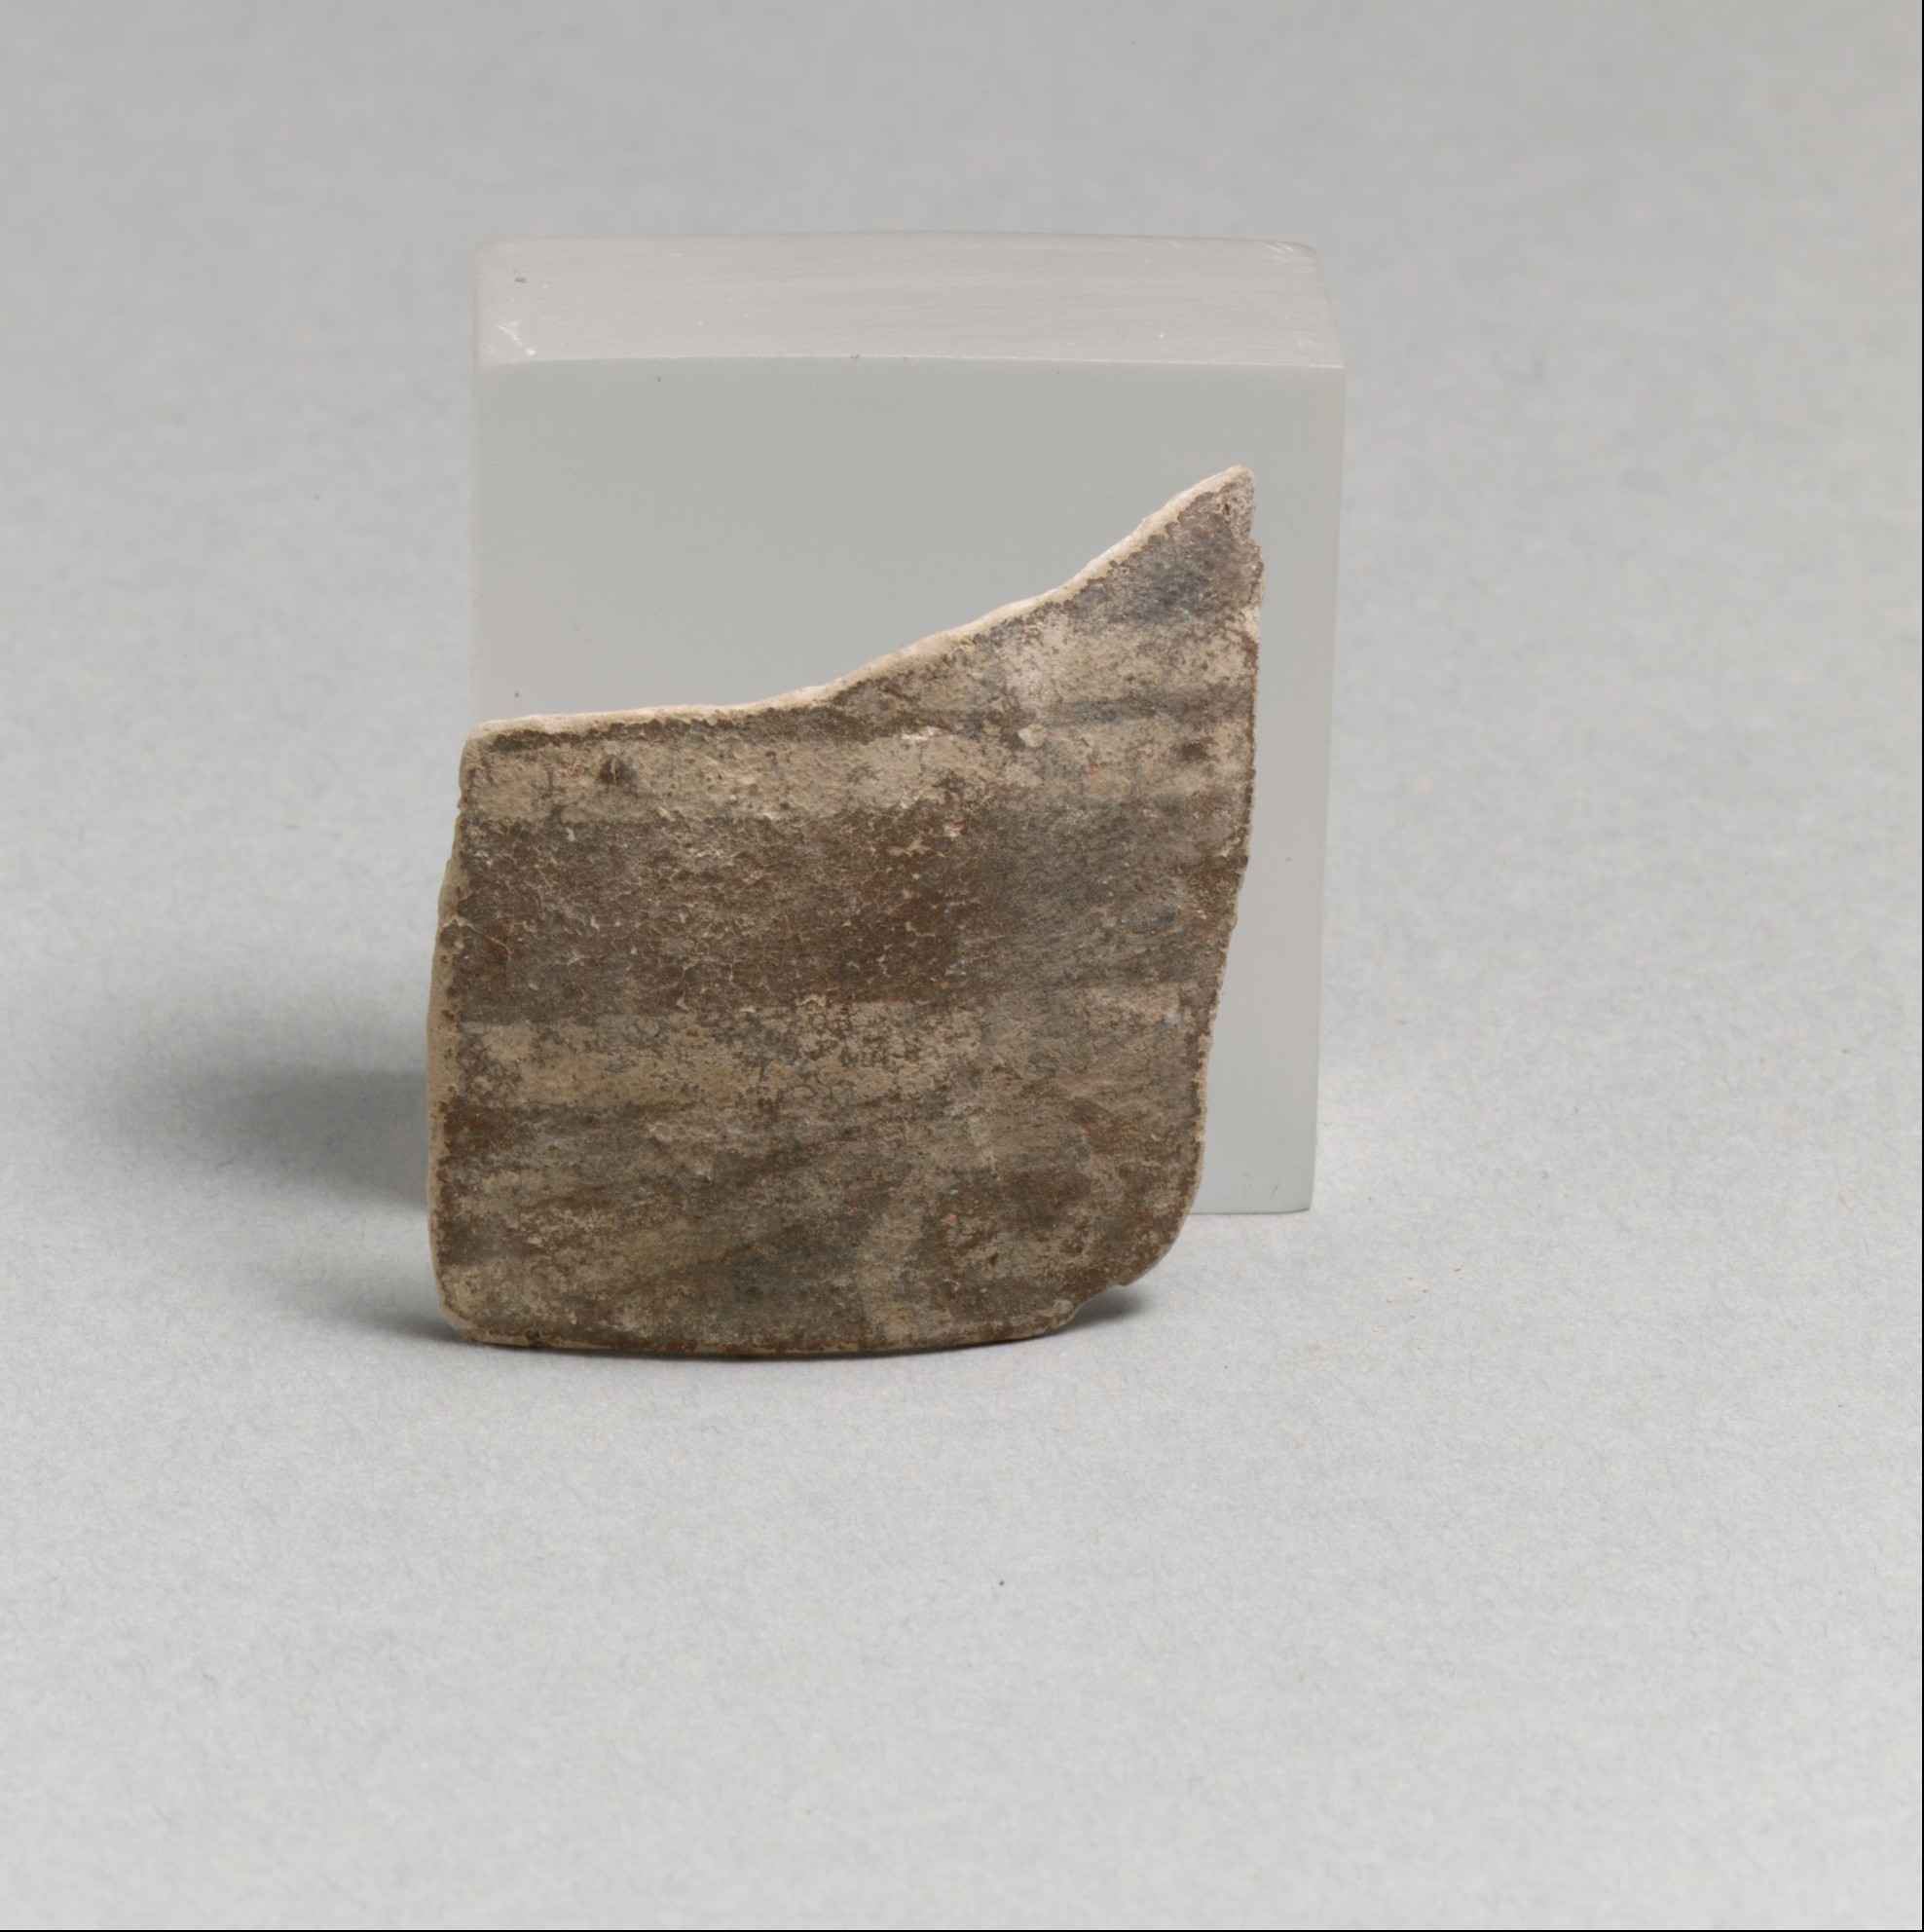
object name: vase fragment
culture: minoan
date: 2600-2000 BCE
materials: terracotta